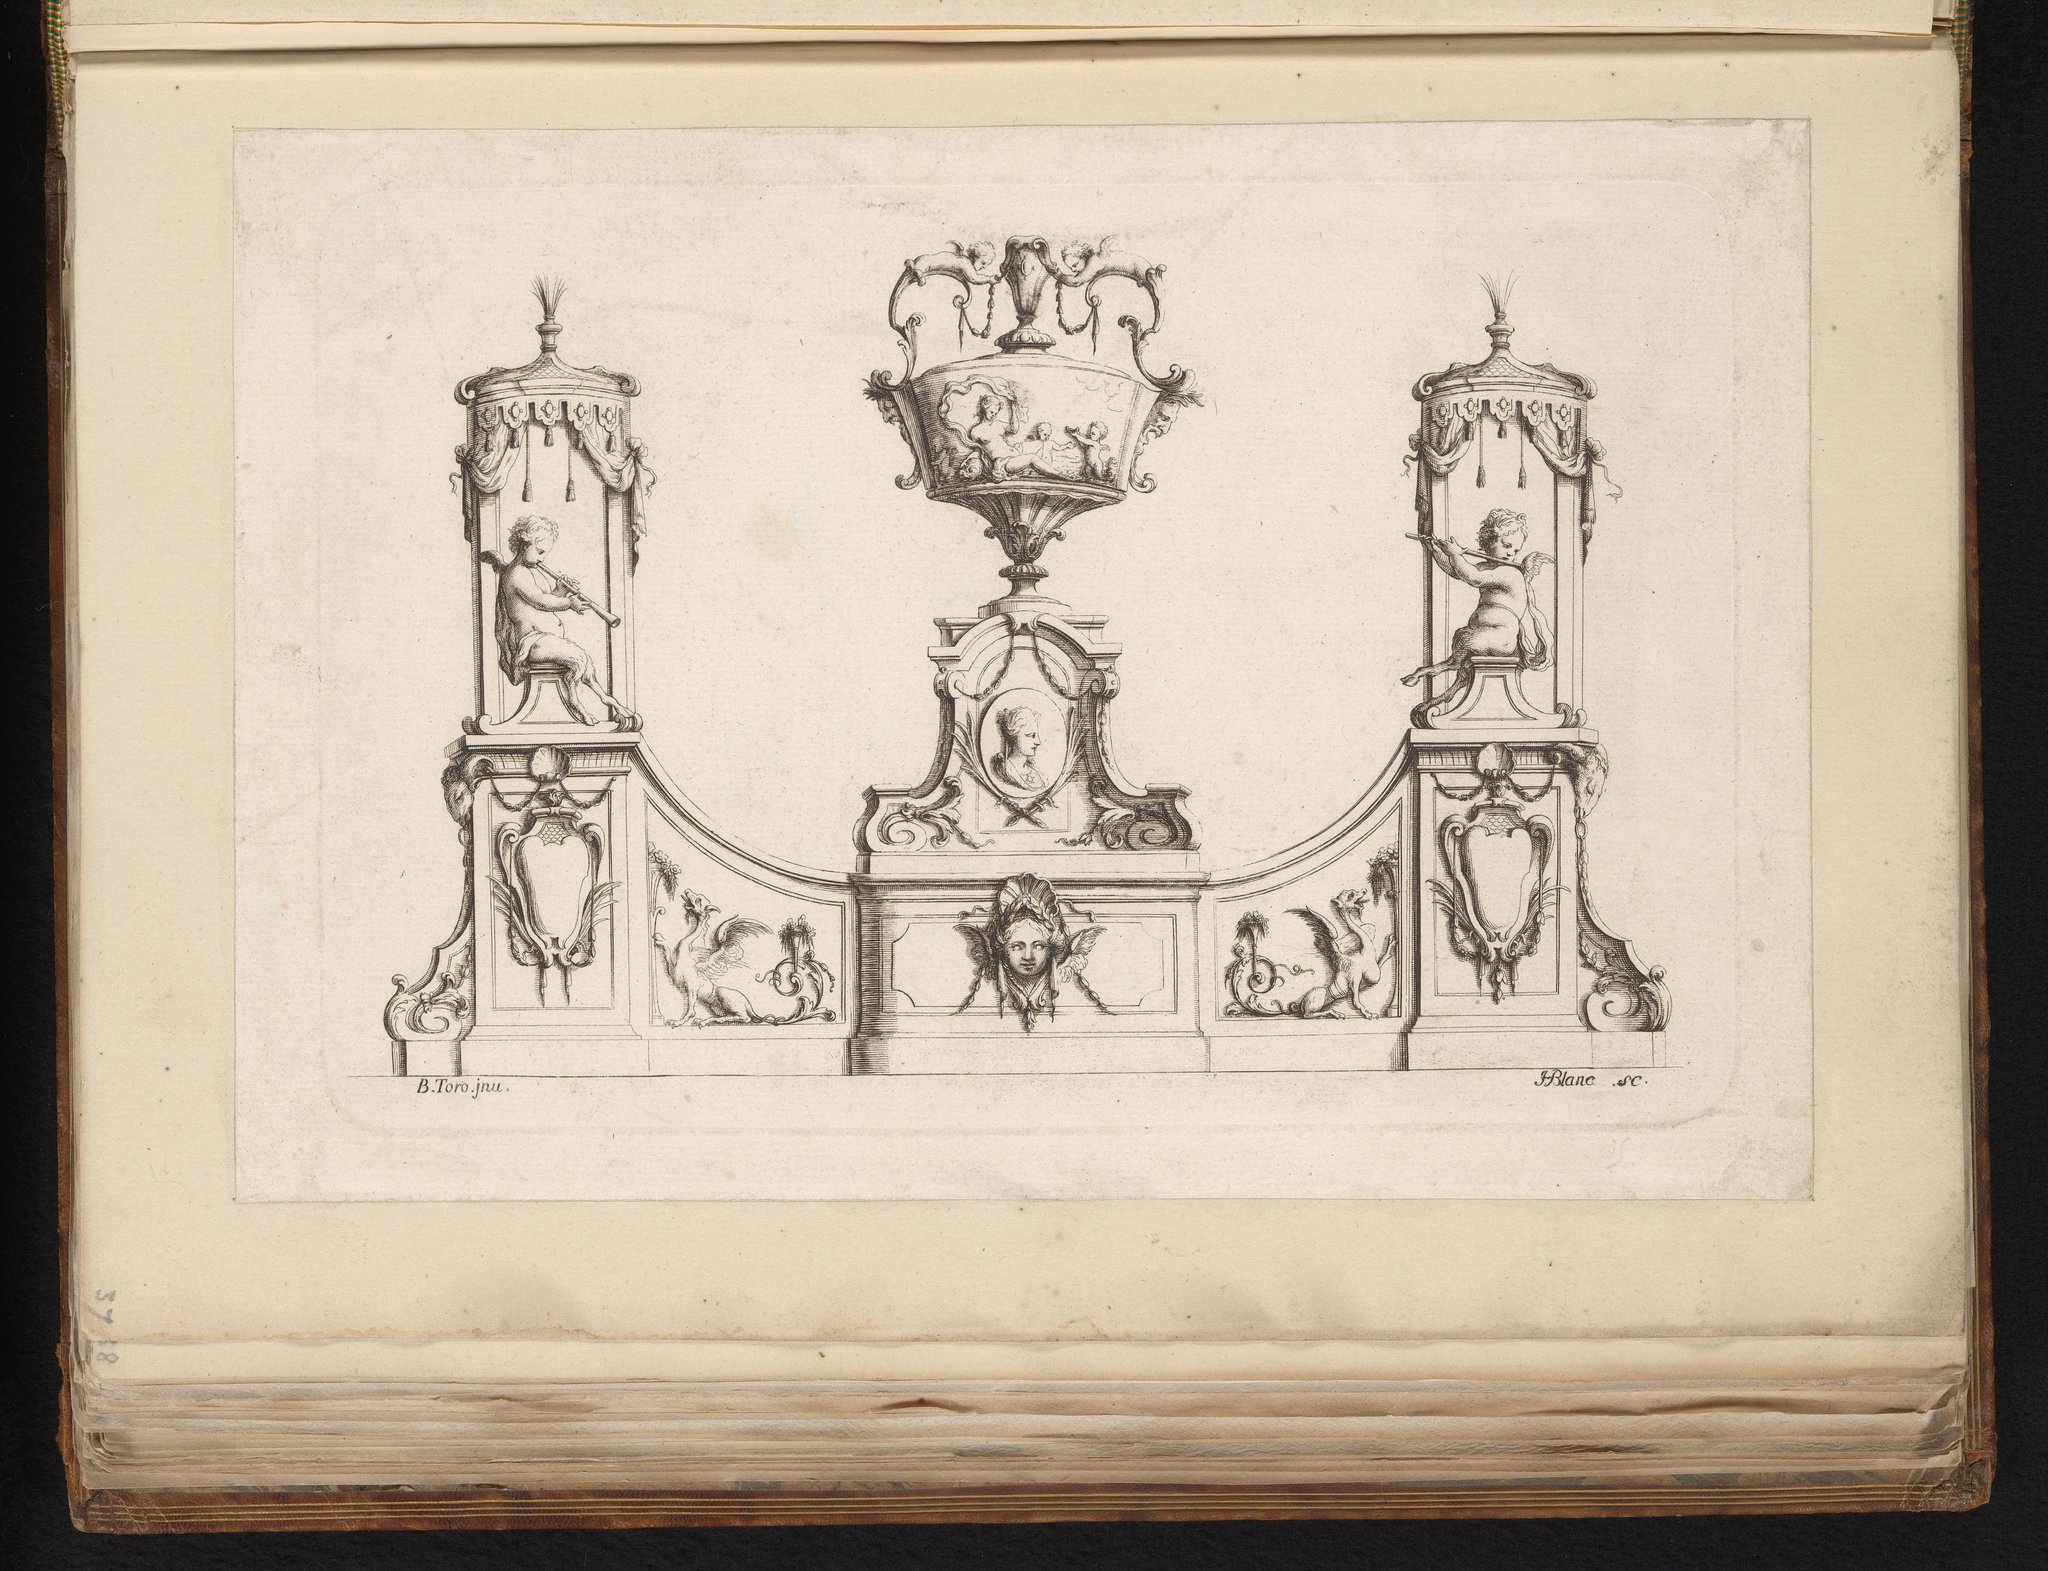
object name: ornament print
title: Desseins a plusieurs usages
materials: paper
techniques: etching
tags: griffin (lion/eagle); 'griffo' (ripa), vase ~ ornament, satyr(s) (in general), (story of) venus (aphrodite)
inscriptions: collector's mark: Lugt 2228, collector's mark: Lugt 2760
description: Op de vaas een decoratie van Venus en putti. Prent maakt deel uit van een album.